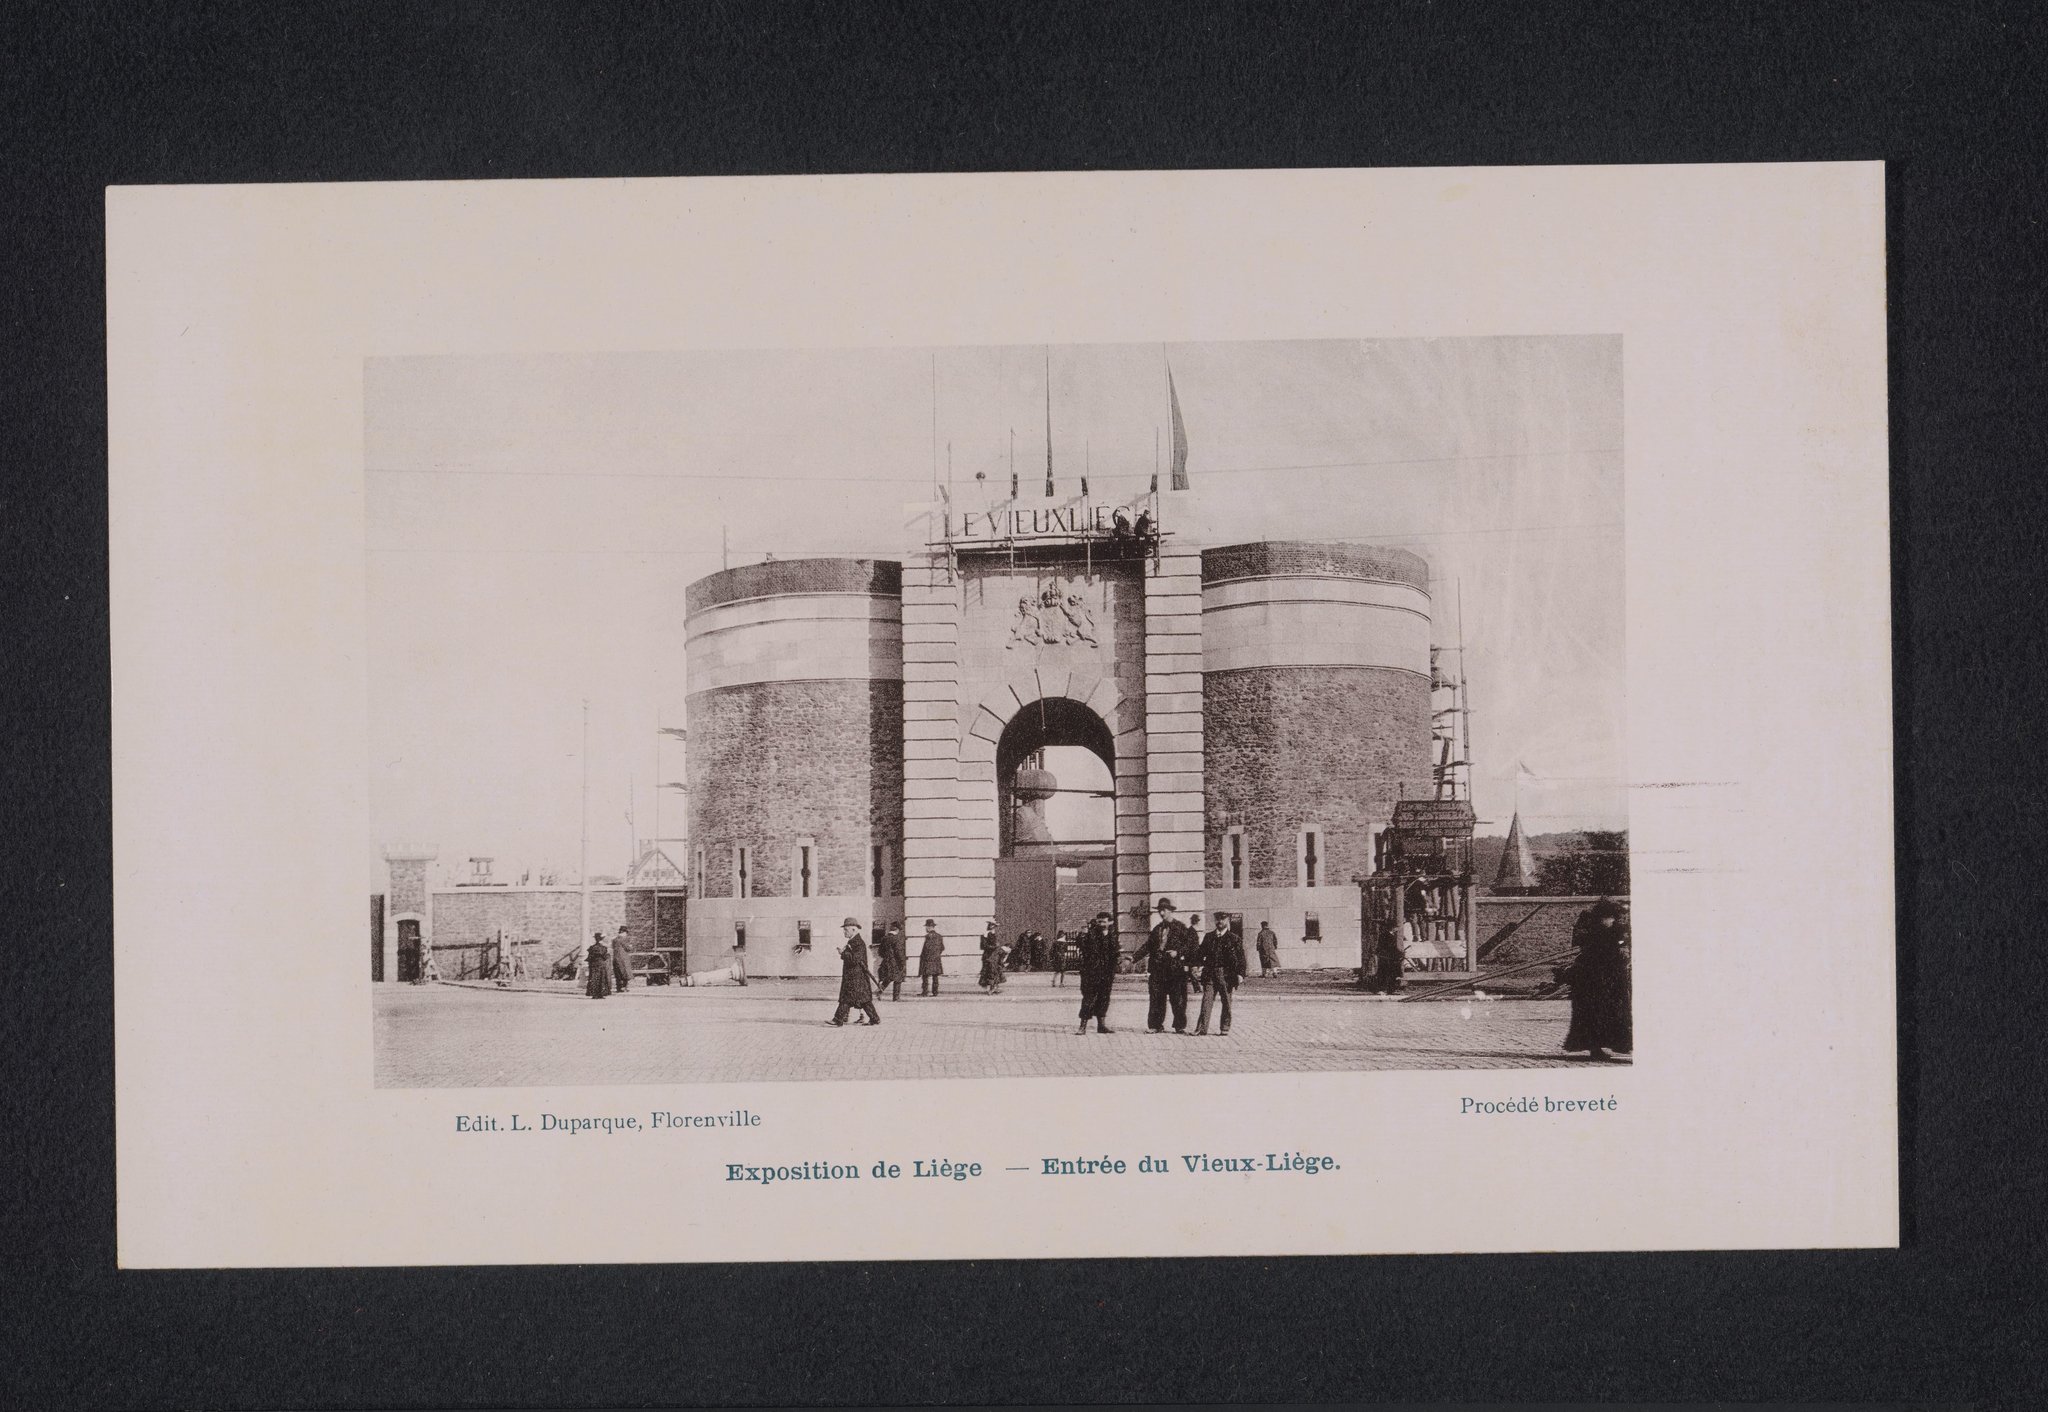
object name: photomechanical print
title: Gezicht op de entree van Vieux-Liège op de Wereldtentoonstelling van 1905 in Luik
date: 1905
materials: paper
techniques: photograph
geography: florenville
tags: world fair, world exhibition, gate, entrance, liège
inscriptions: inscription: ‘Procédé breveté’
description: Deze prent maakt deel uit van een omslag met 16 prenten.